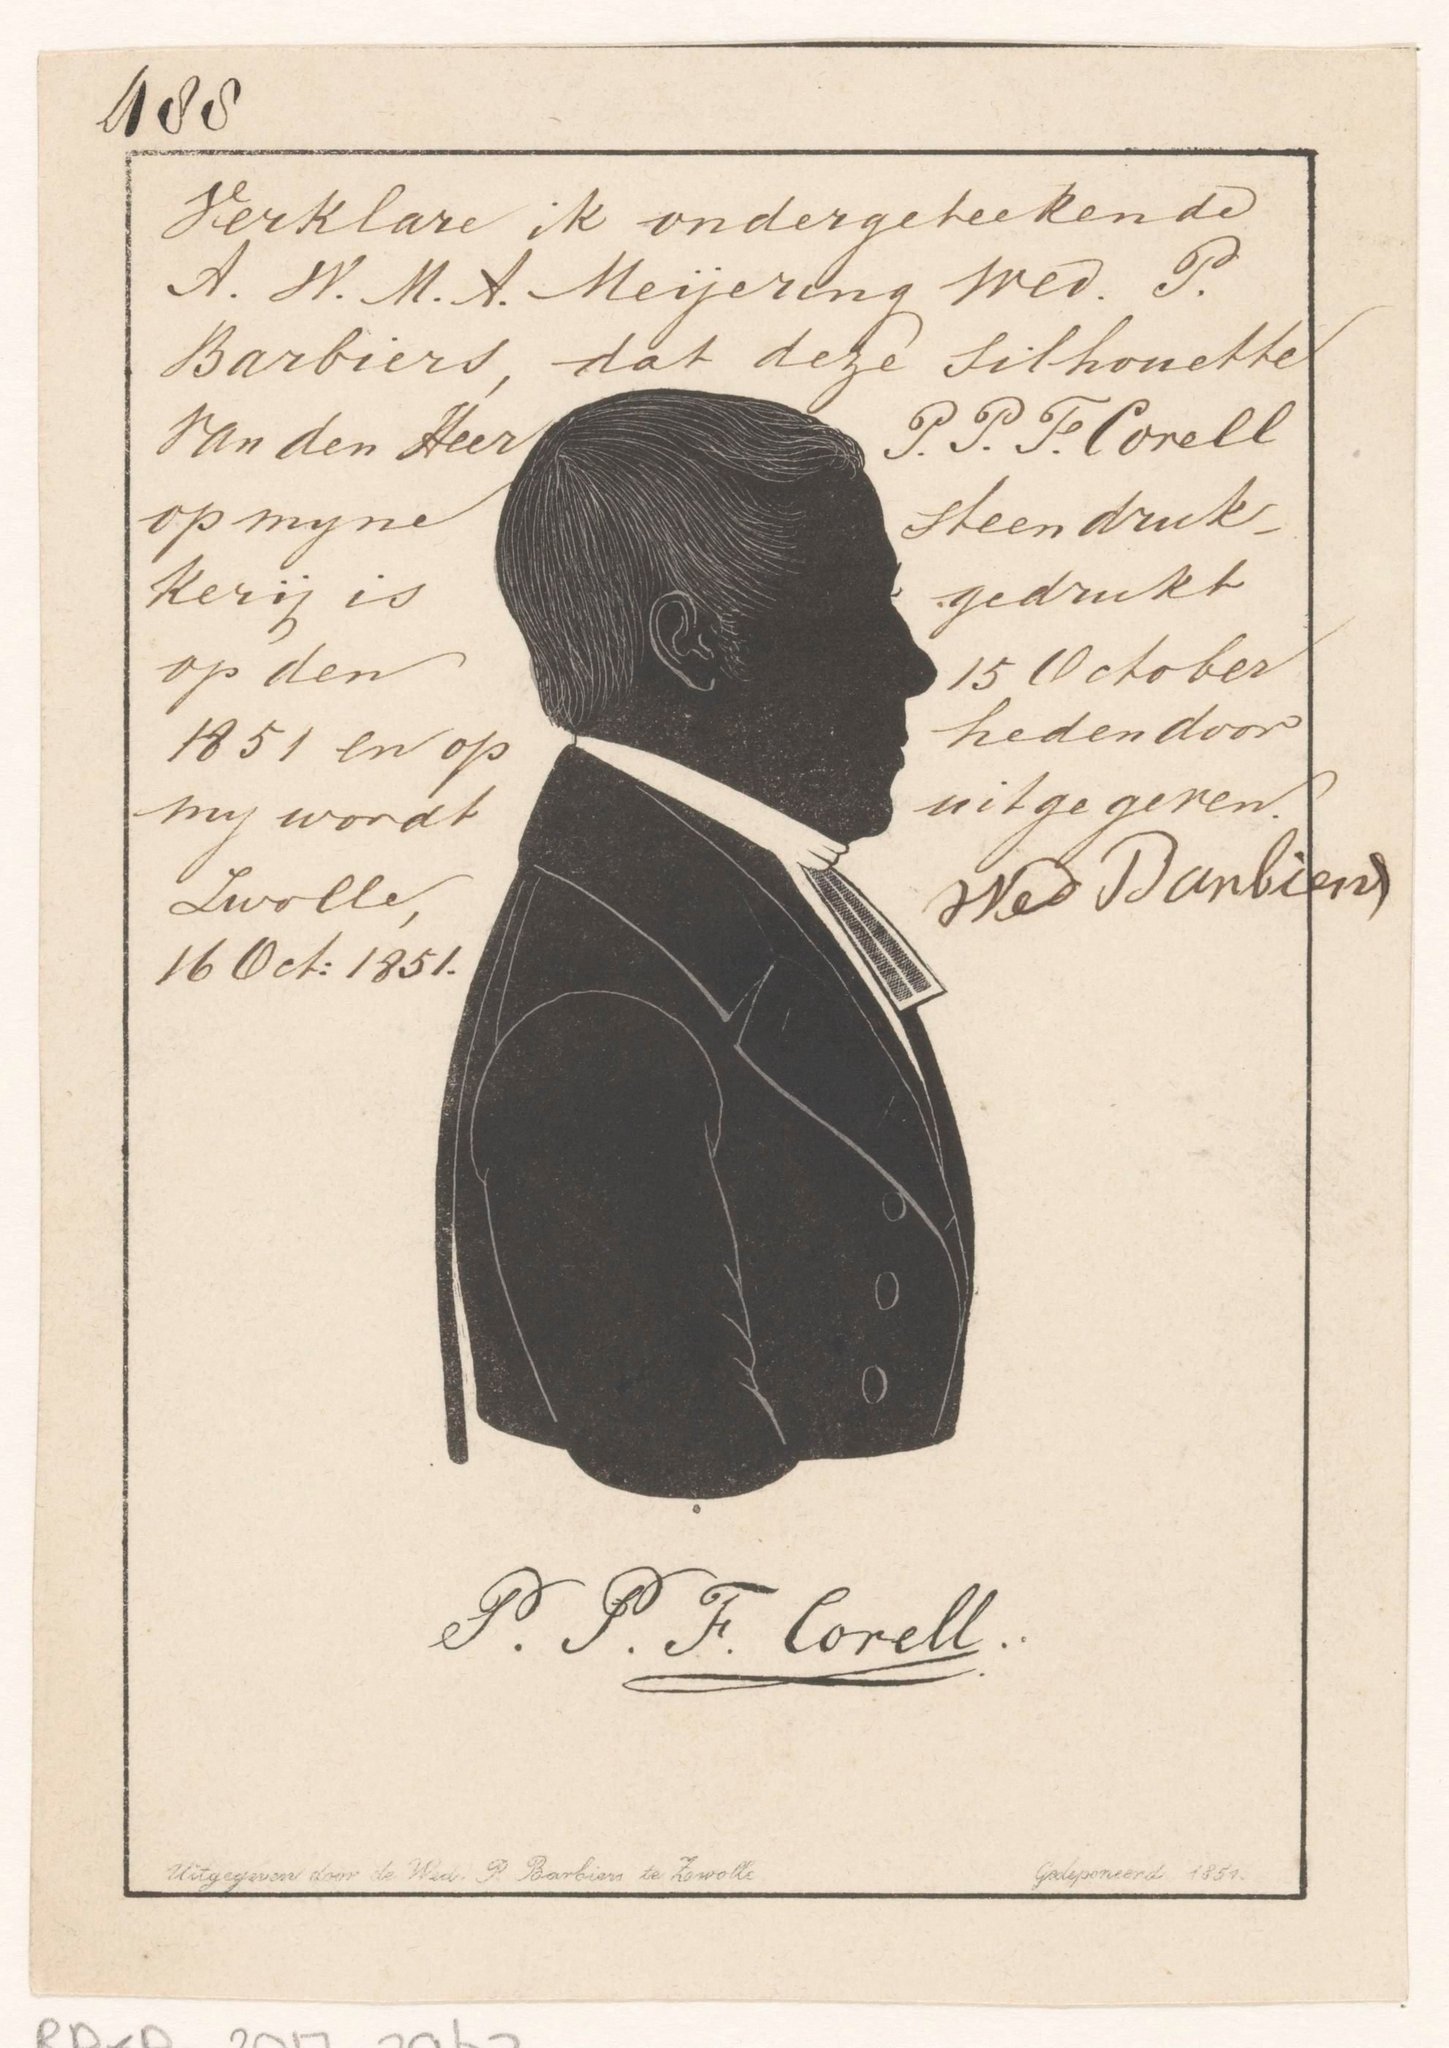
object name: print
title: Silhouetportret van Petrus Paulus Fredericus Corell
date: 1851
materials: paper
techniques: hand coloring, lithograph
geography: zwolle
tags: historical persons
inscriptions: collector's mark: Lugt 2228, inscription: ‘Verklare ik ondergeteekende A.W.M.A. Meijering Wed. P. Barbiers dat deze silhouette van den Heer P.P.F. Corell op mijne steendrukkerij is gedrukt op den 15 October 1851 en op heden door mij wordt uitgegeven. Zwolle, Wed Barbiers 16 Oct. 1851’, : ‘Gedeponeerd 1851.’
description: Onder het portret de signatuur van de geportretteerde.